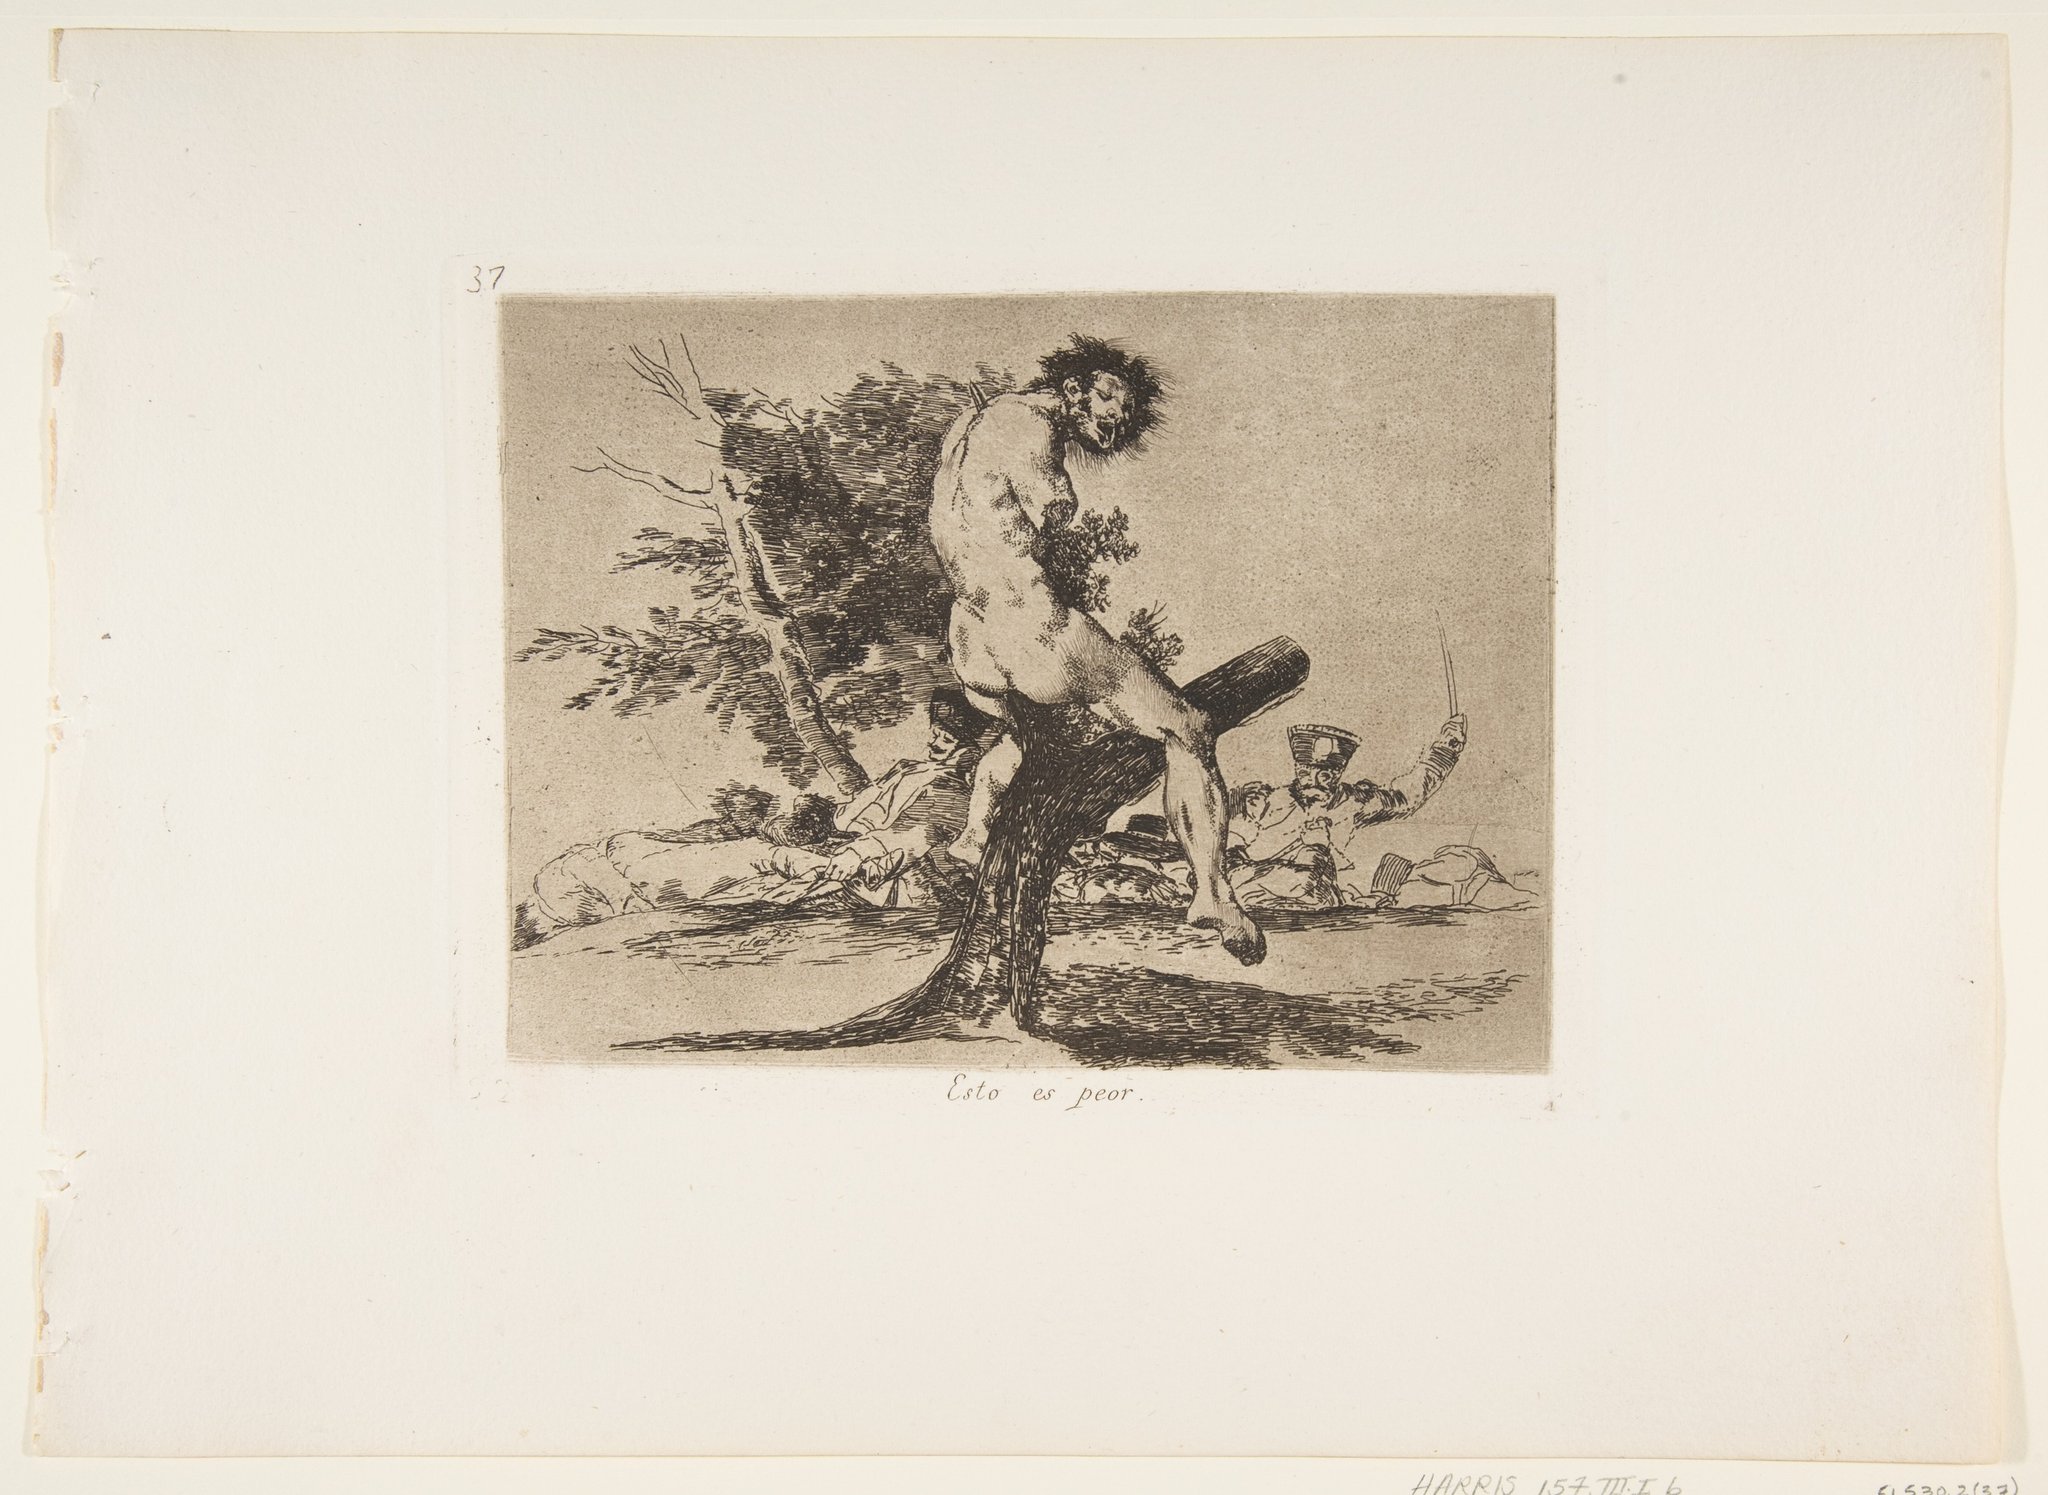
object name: print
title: Plate 37 from "The Disasters of War" (Los Desastres de La Guerra): 'This is worse' (Esto es peor)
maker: goya (francisco de goya y lucientes)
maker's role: artist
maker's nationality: spanish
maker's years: 1746-1828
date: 1810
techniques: drypoint, etching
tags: male nudes,trees